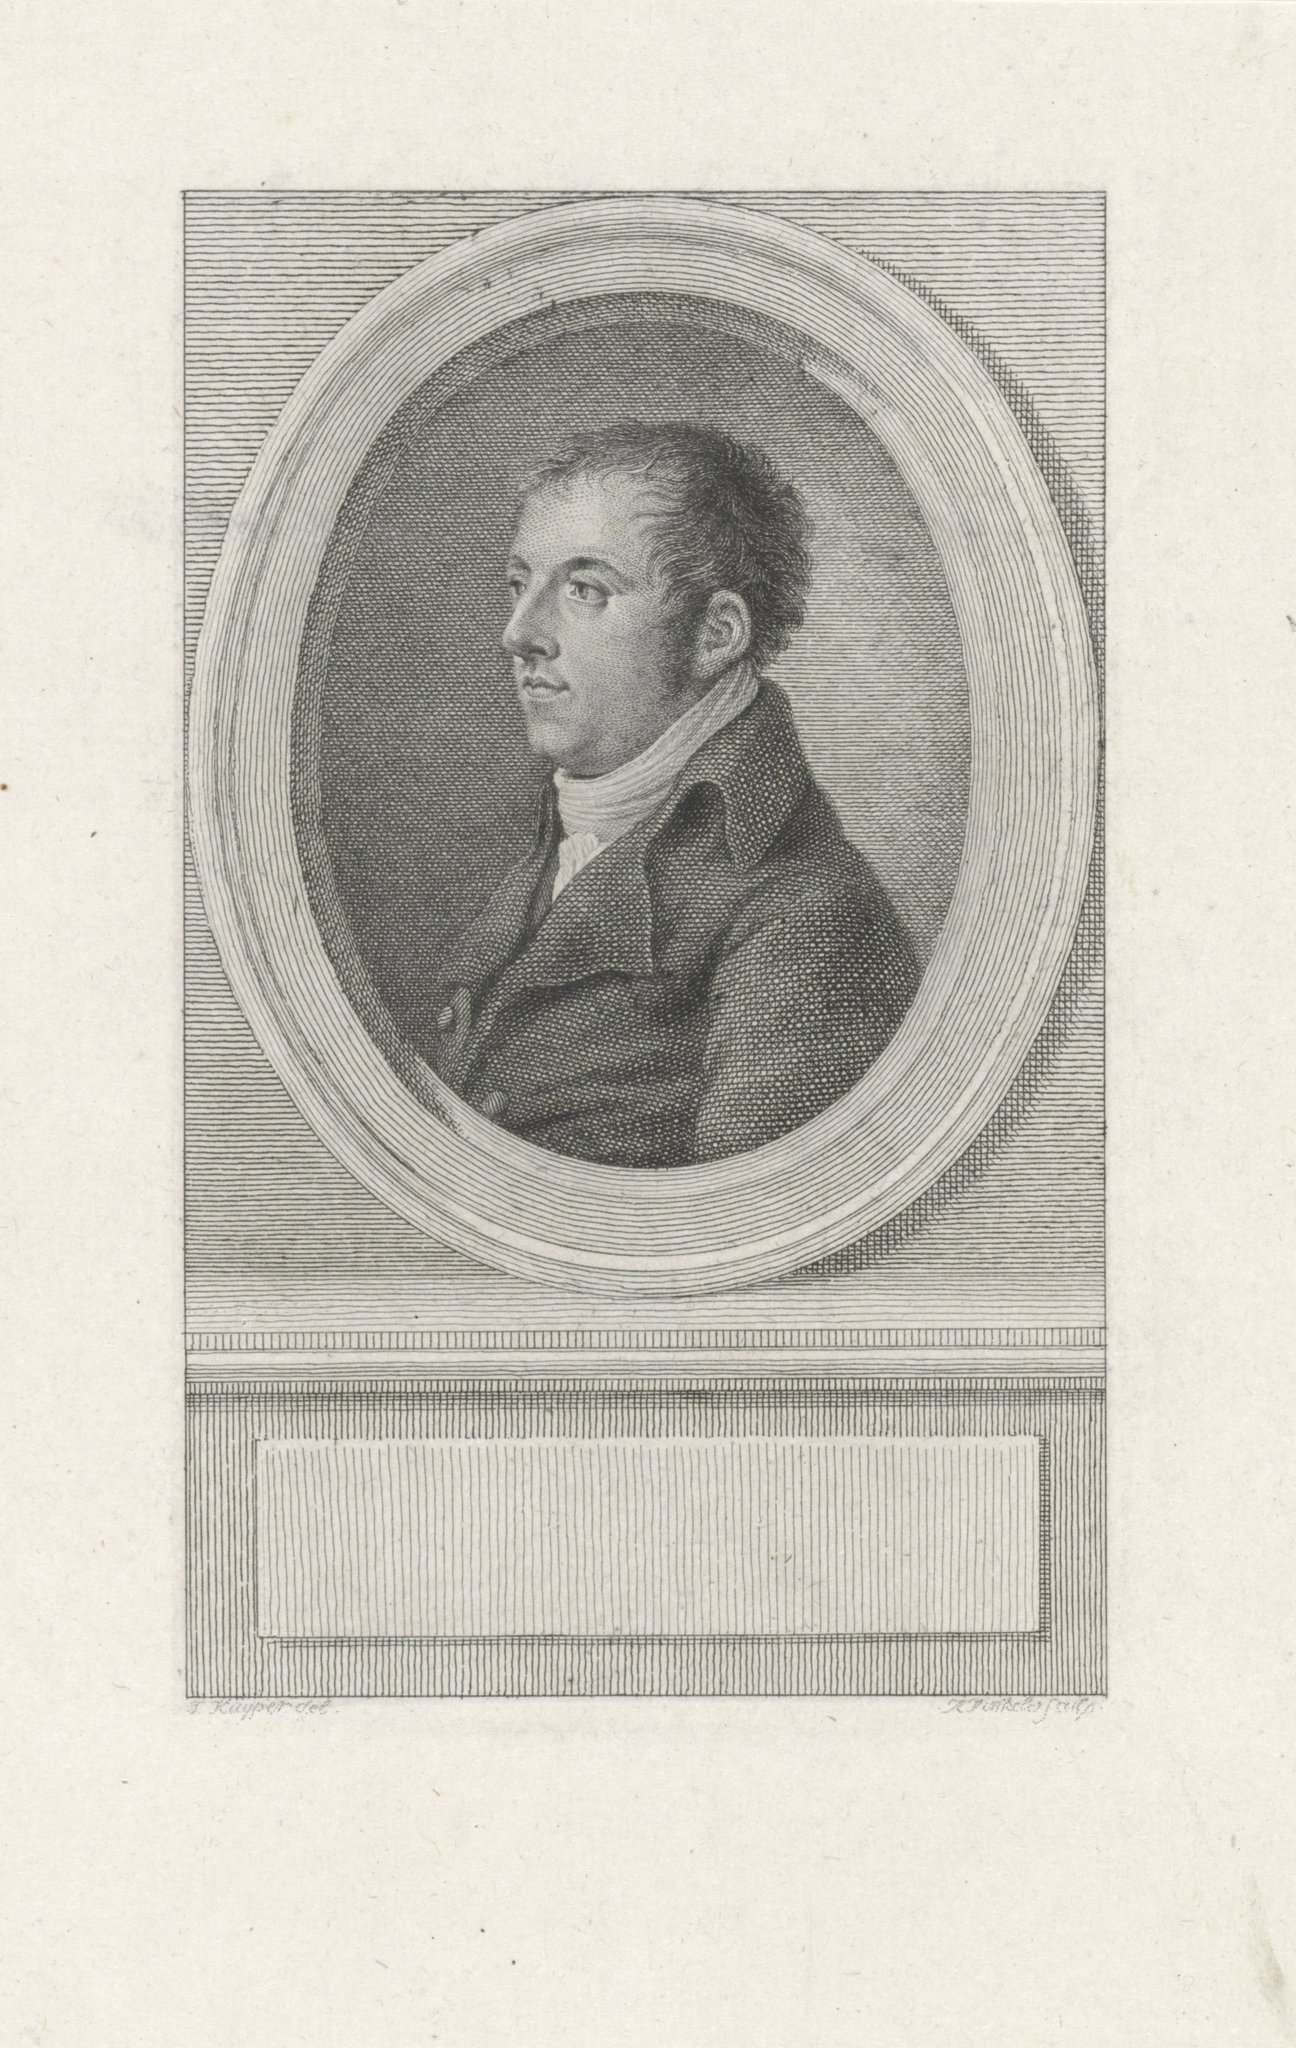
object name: print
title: Portret van Rutger Jan Schimmelpenninck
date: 1805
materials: paper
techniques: engraving, etching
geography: amsterdam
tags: deventer, rutger jan schimmelpenninck (1761-1825)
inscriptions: collector's mark: Lugt 2228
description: Latere staat prent ook gebruikt als boekillustratie in: Wagenaar, Jan. Vaderlandsche historie, (...) ten vervolge van Wagenaars Vaderlandsche historie. 43 dln. Amsterdam: Johannes Allart, 1805, dl. 35.